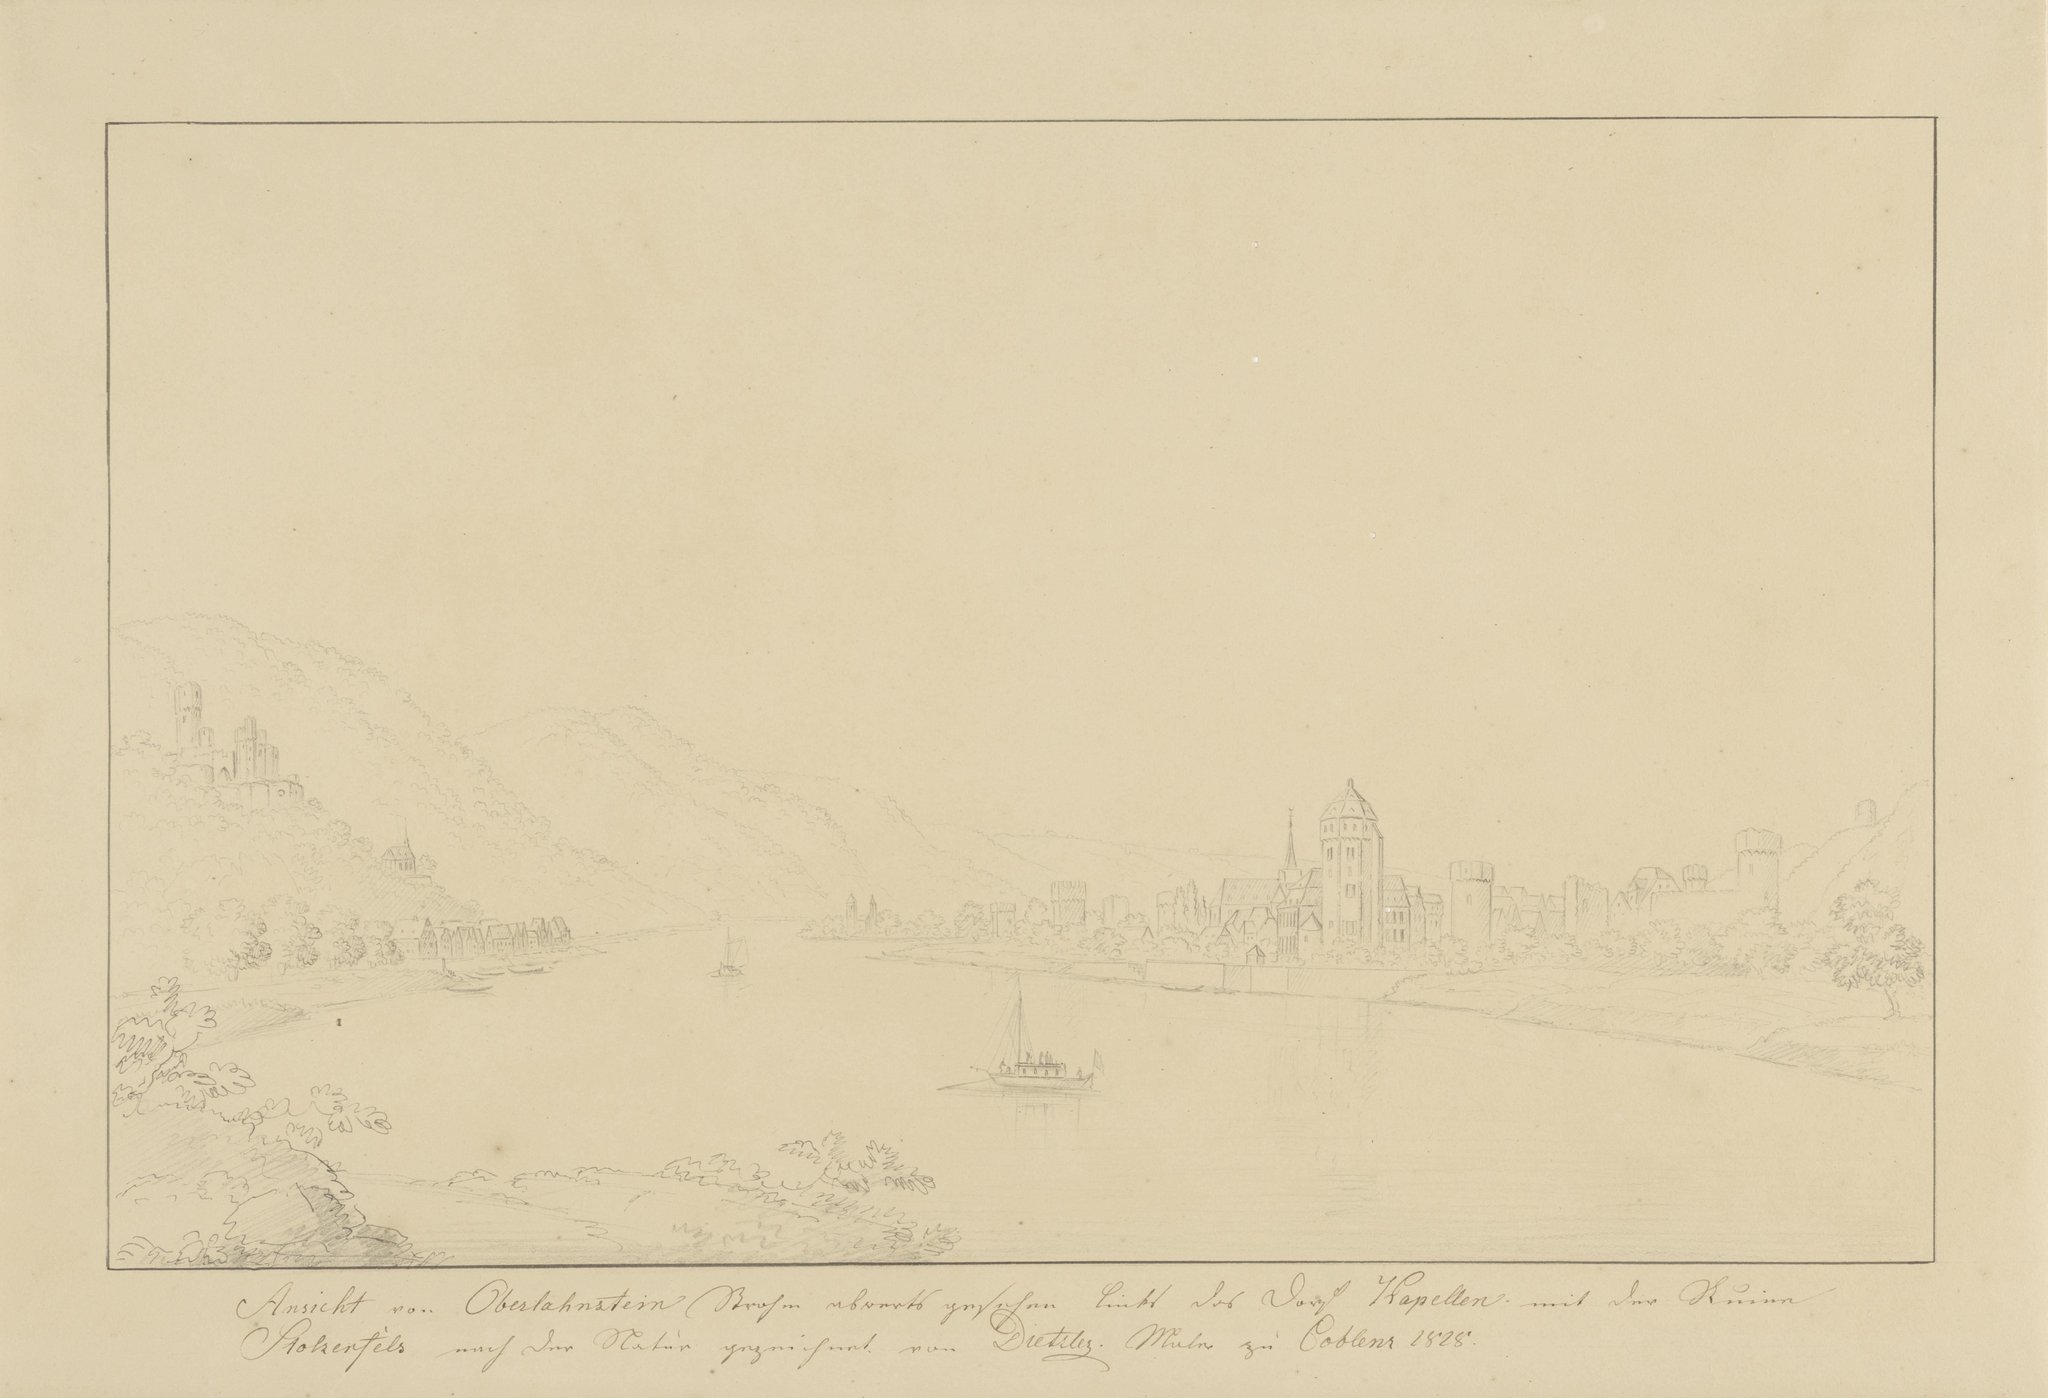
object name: drawing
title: Gezicht op Oberlahnstein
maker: jakob dietzler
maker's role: draughtsman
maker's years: 1789-1855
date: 1828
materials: ink, paper, pencil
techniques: pen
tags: river, prospect of city, town panorama, silhouette of city (+ city(-scape) with figures, staffage)